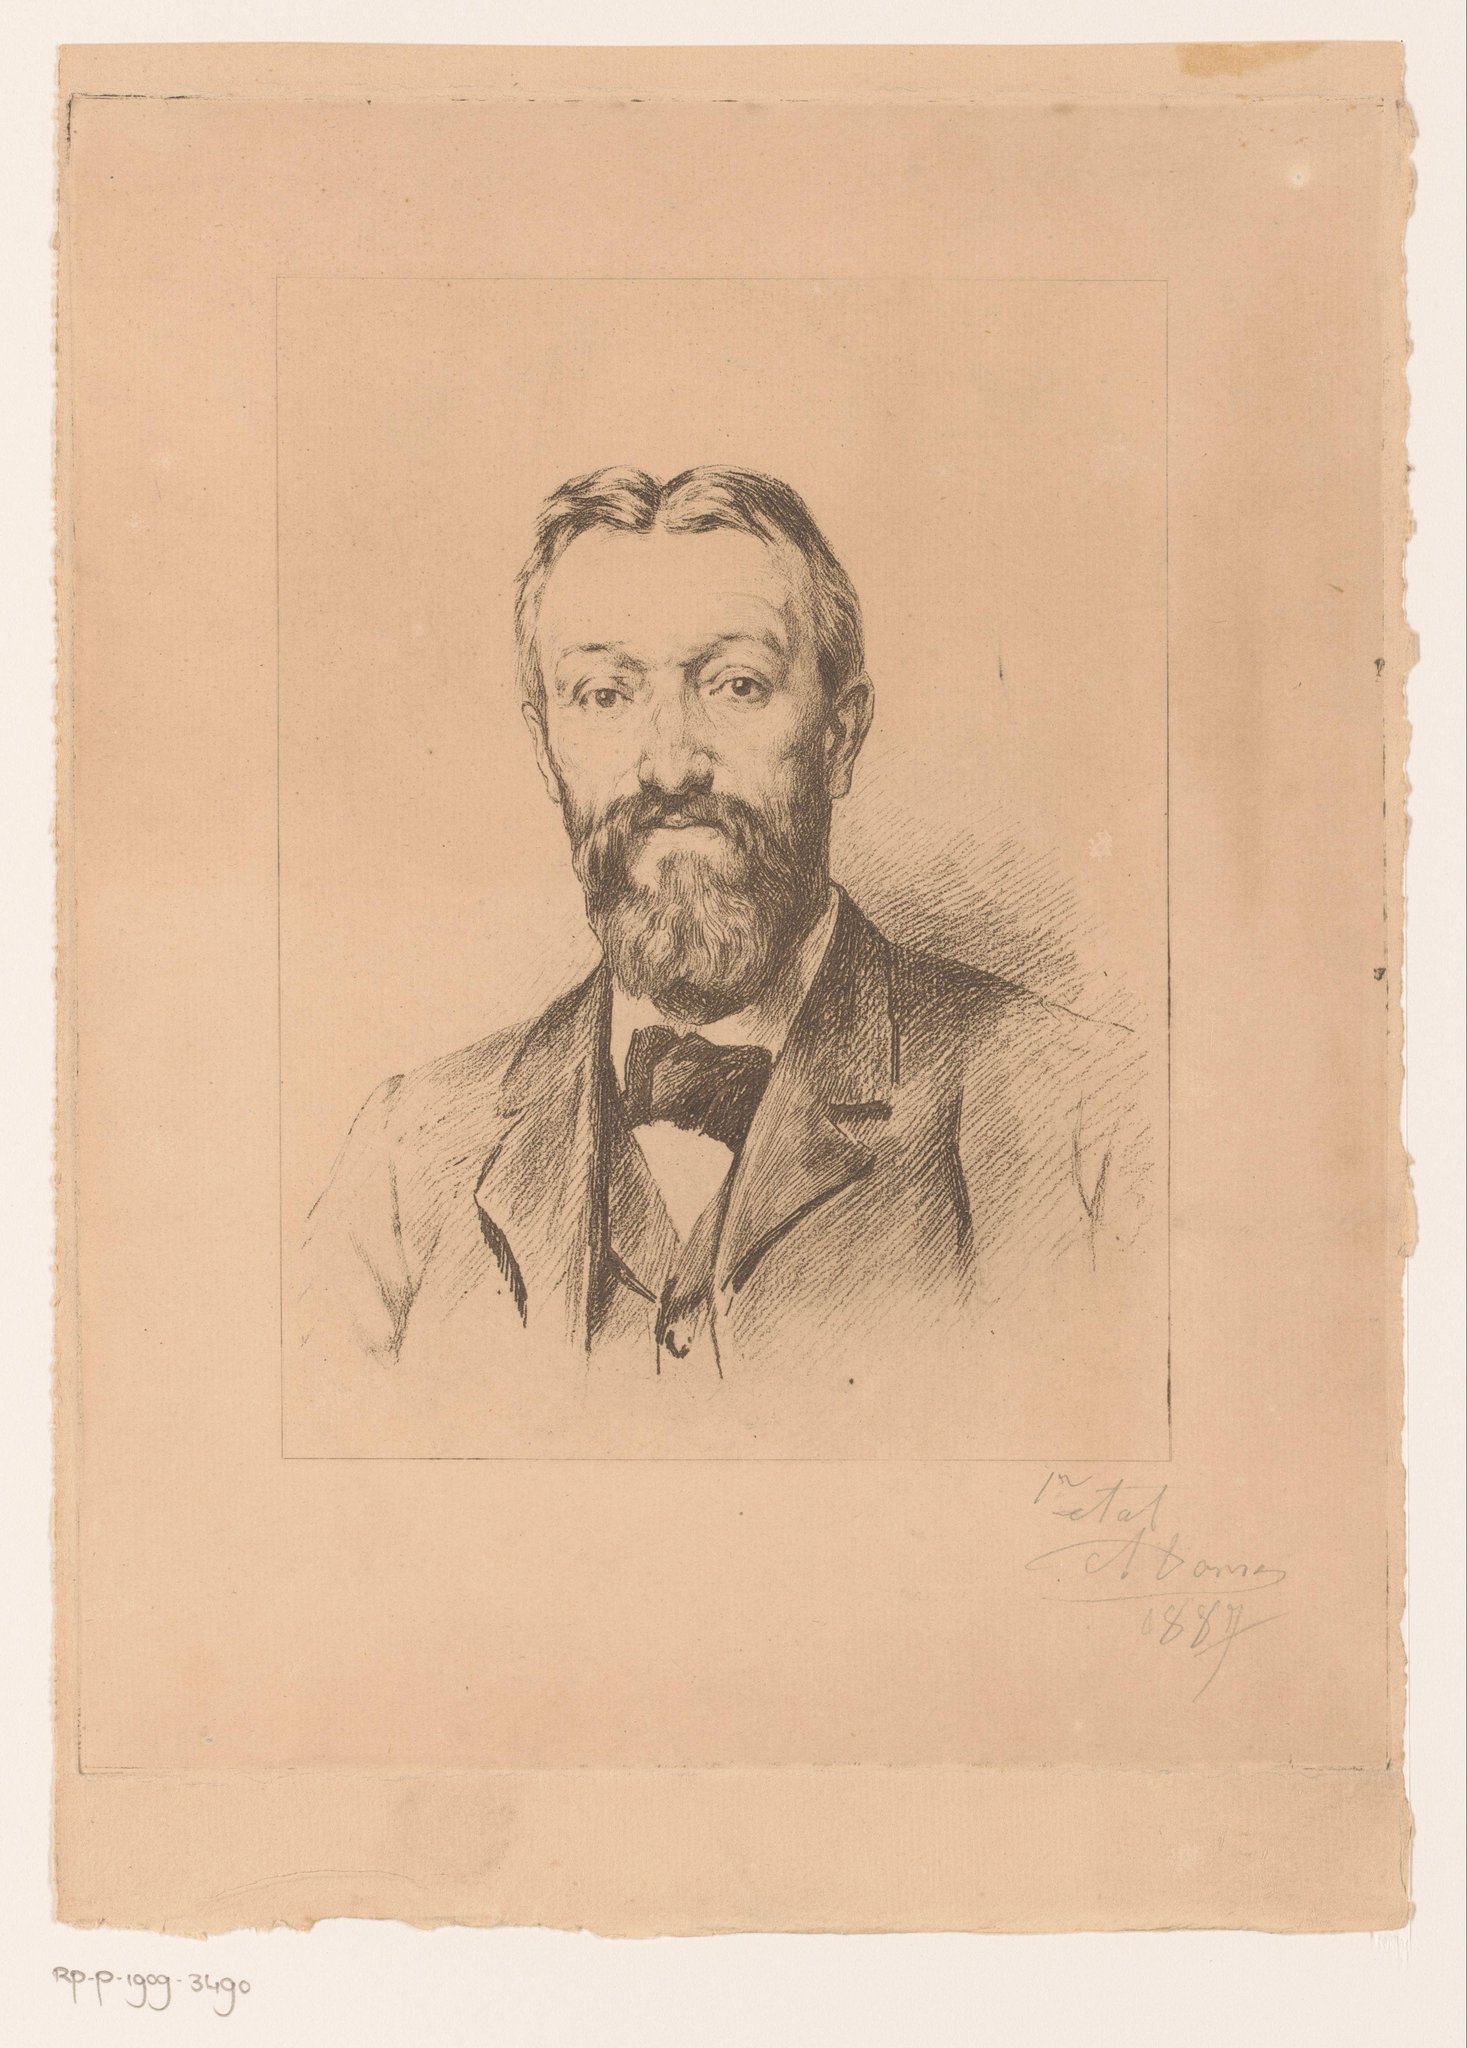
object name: print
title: Portret van Emile de Mot, schepen en later burgemeester van Brussel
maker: auguste danse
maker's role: print maker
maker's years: 1829-1929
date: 1887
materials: paper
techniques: etching, soft ground etching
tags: antwerp, politician, mayor, historical person (...) - historical person (...) portrayed alone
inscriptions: annotation: ‘1er état’, collector's mark: Lugt 2228